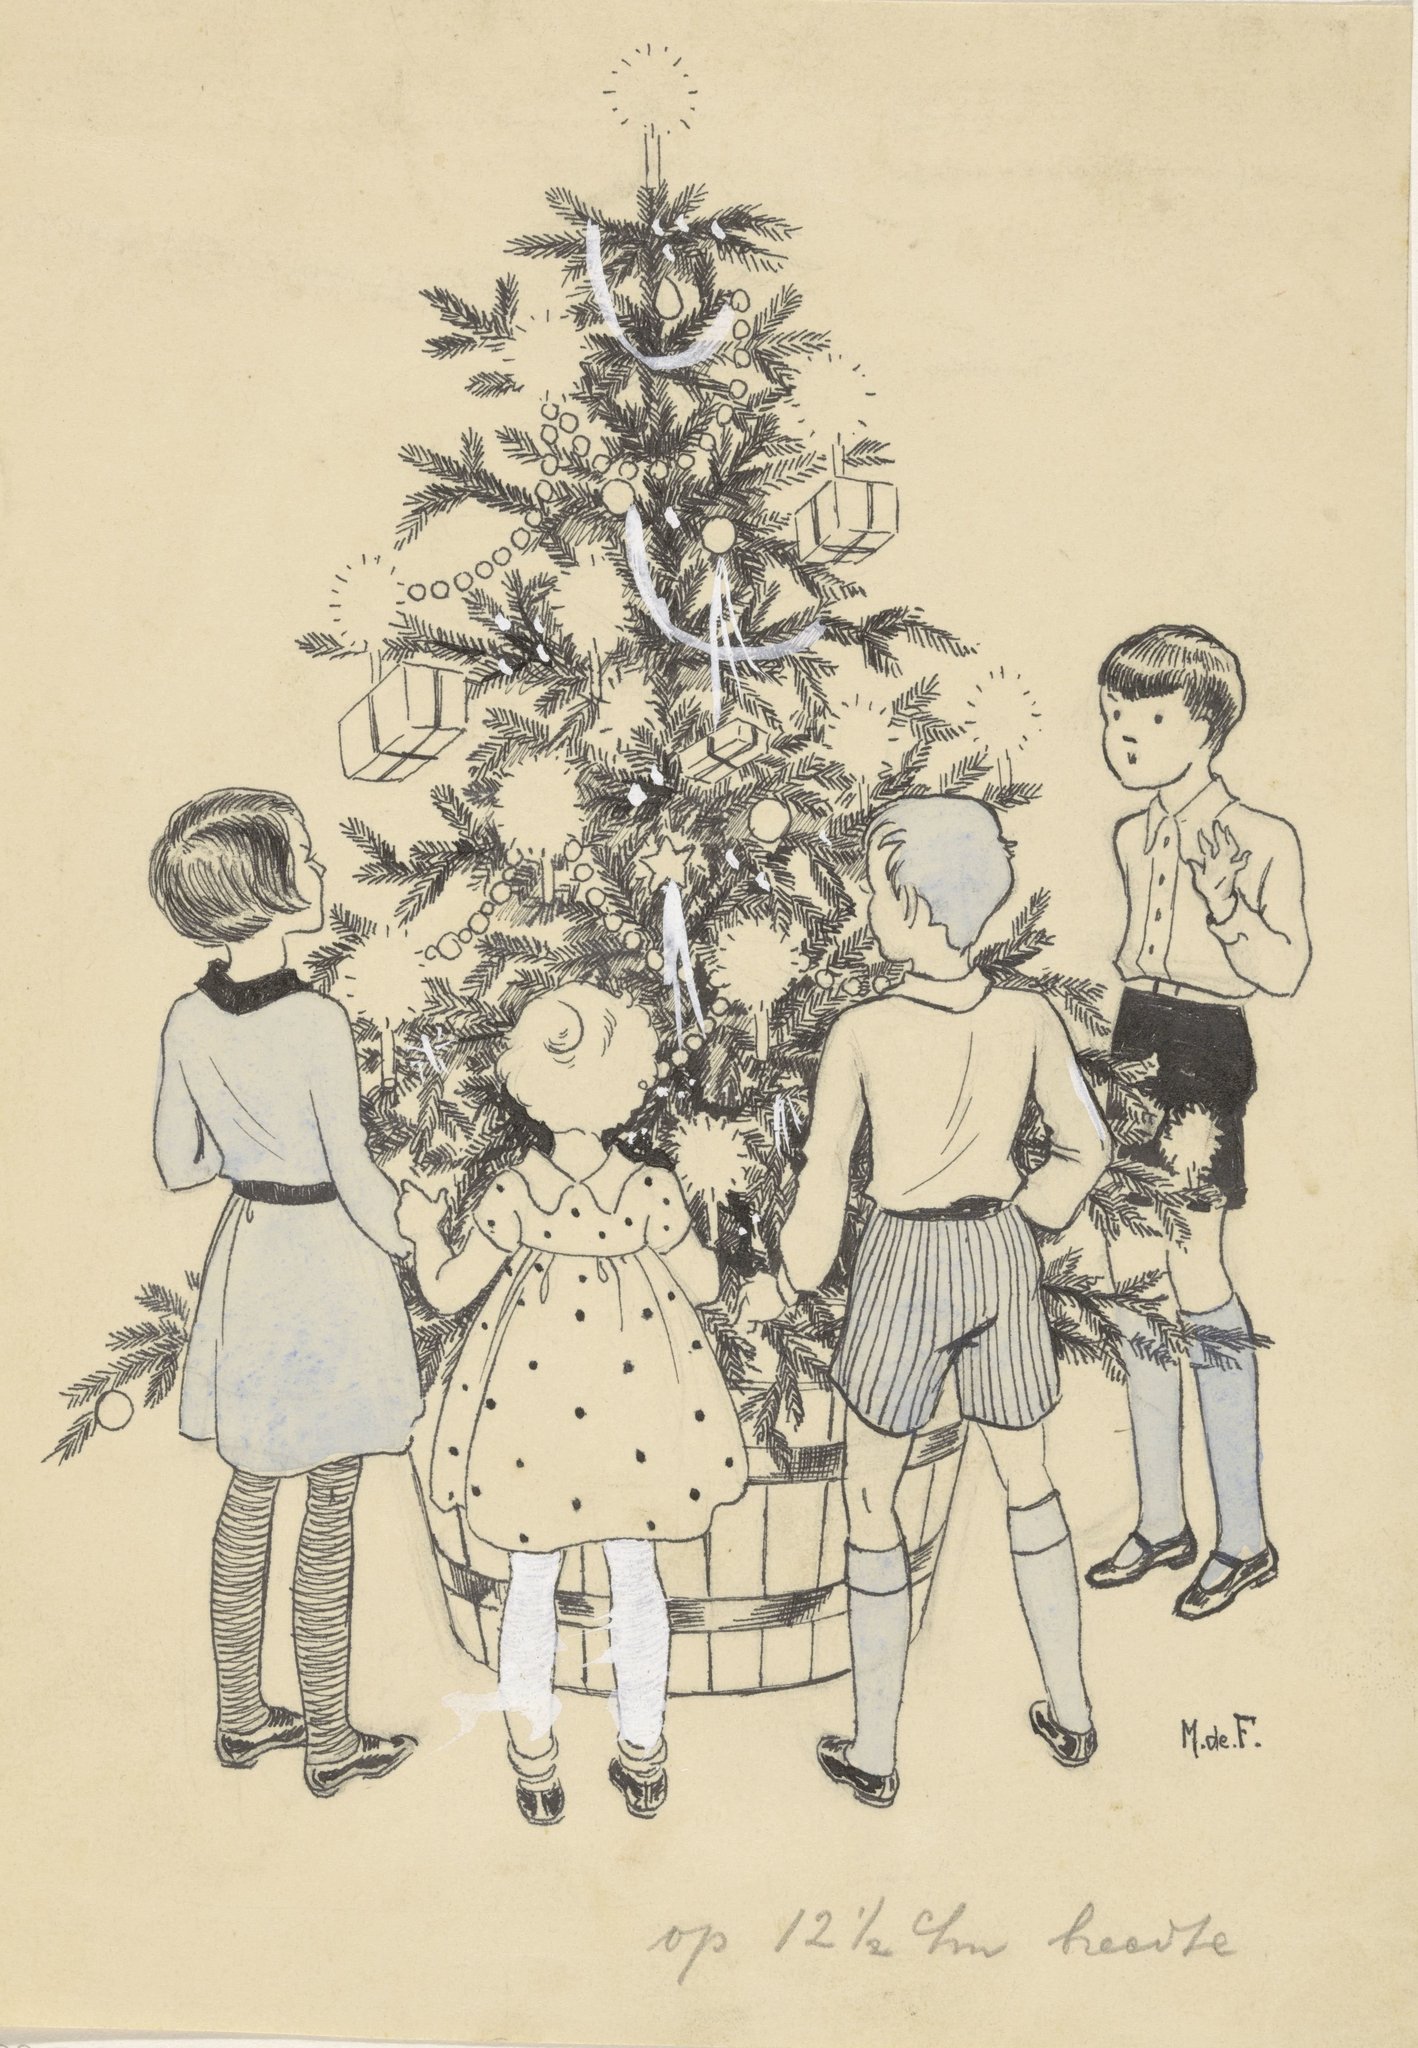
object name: boekillustratie ontwerp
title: Vier kinderen rondom een kerstboom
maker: miep de feijter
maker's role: draughtsman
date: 1928-1941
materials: paint, ink, paper, pencil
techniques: brush, pen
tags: christmas tree, child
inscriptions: collector's mark: Lugt 2228a, signature: ‘M.deF.’, :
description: Twee meisjes en twee jongens staan rond een kerstboom in een houten ton die is versierd met lichtjes, snoeren, pakjes en een piek.